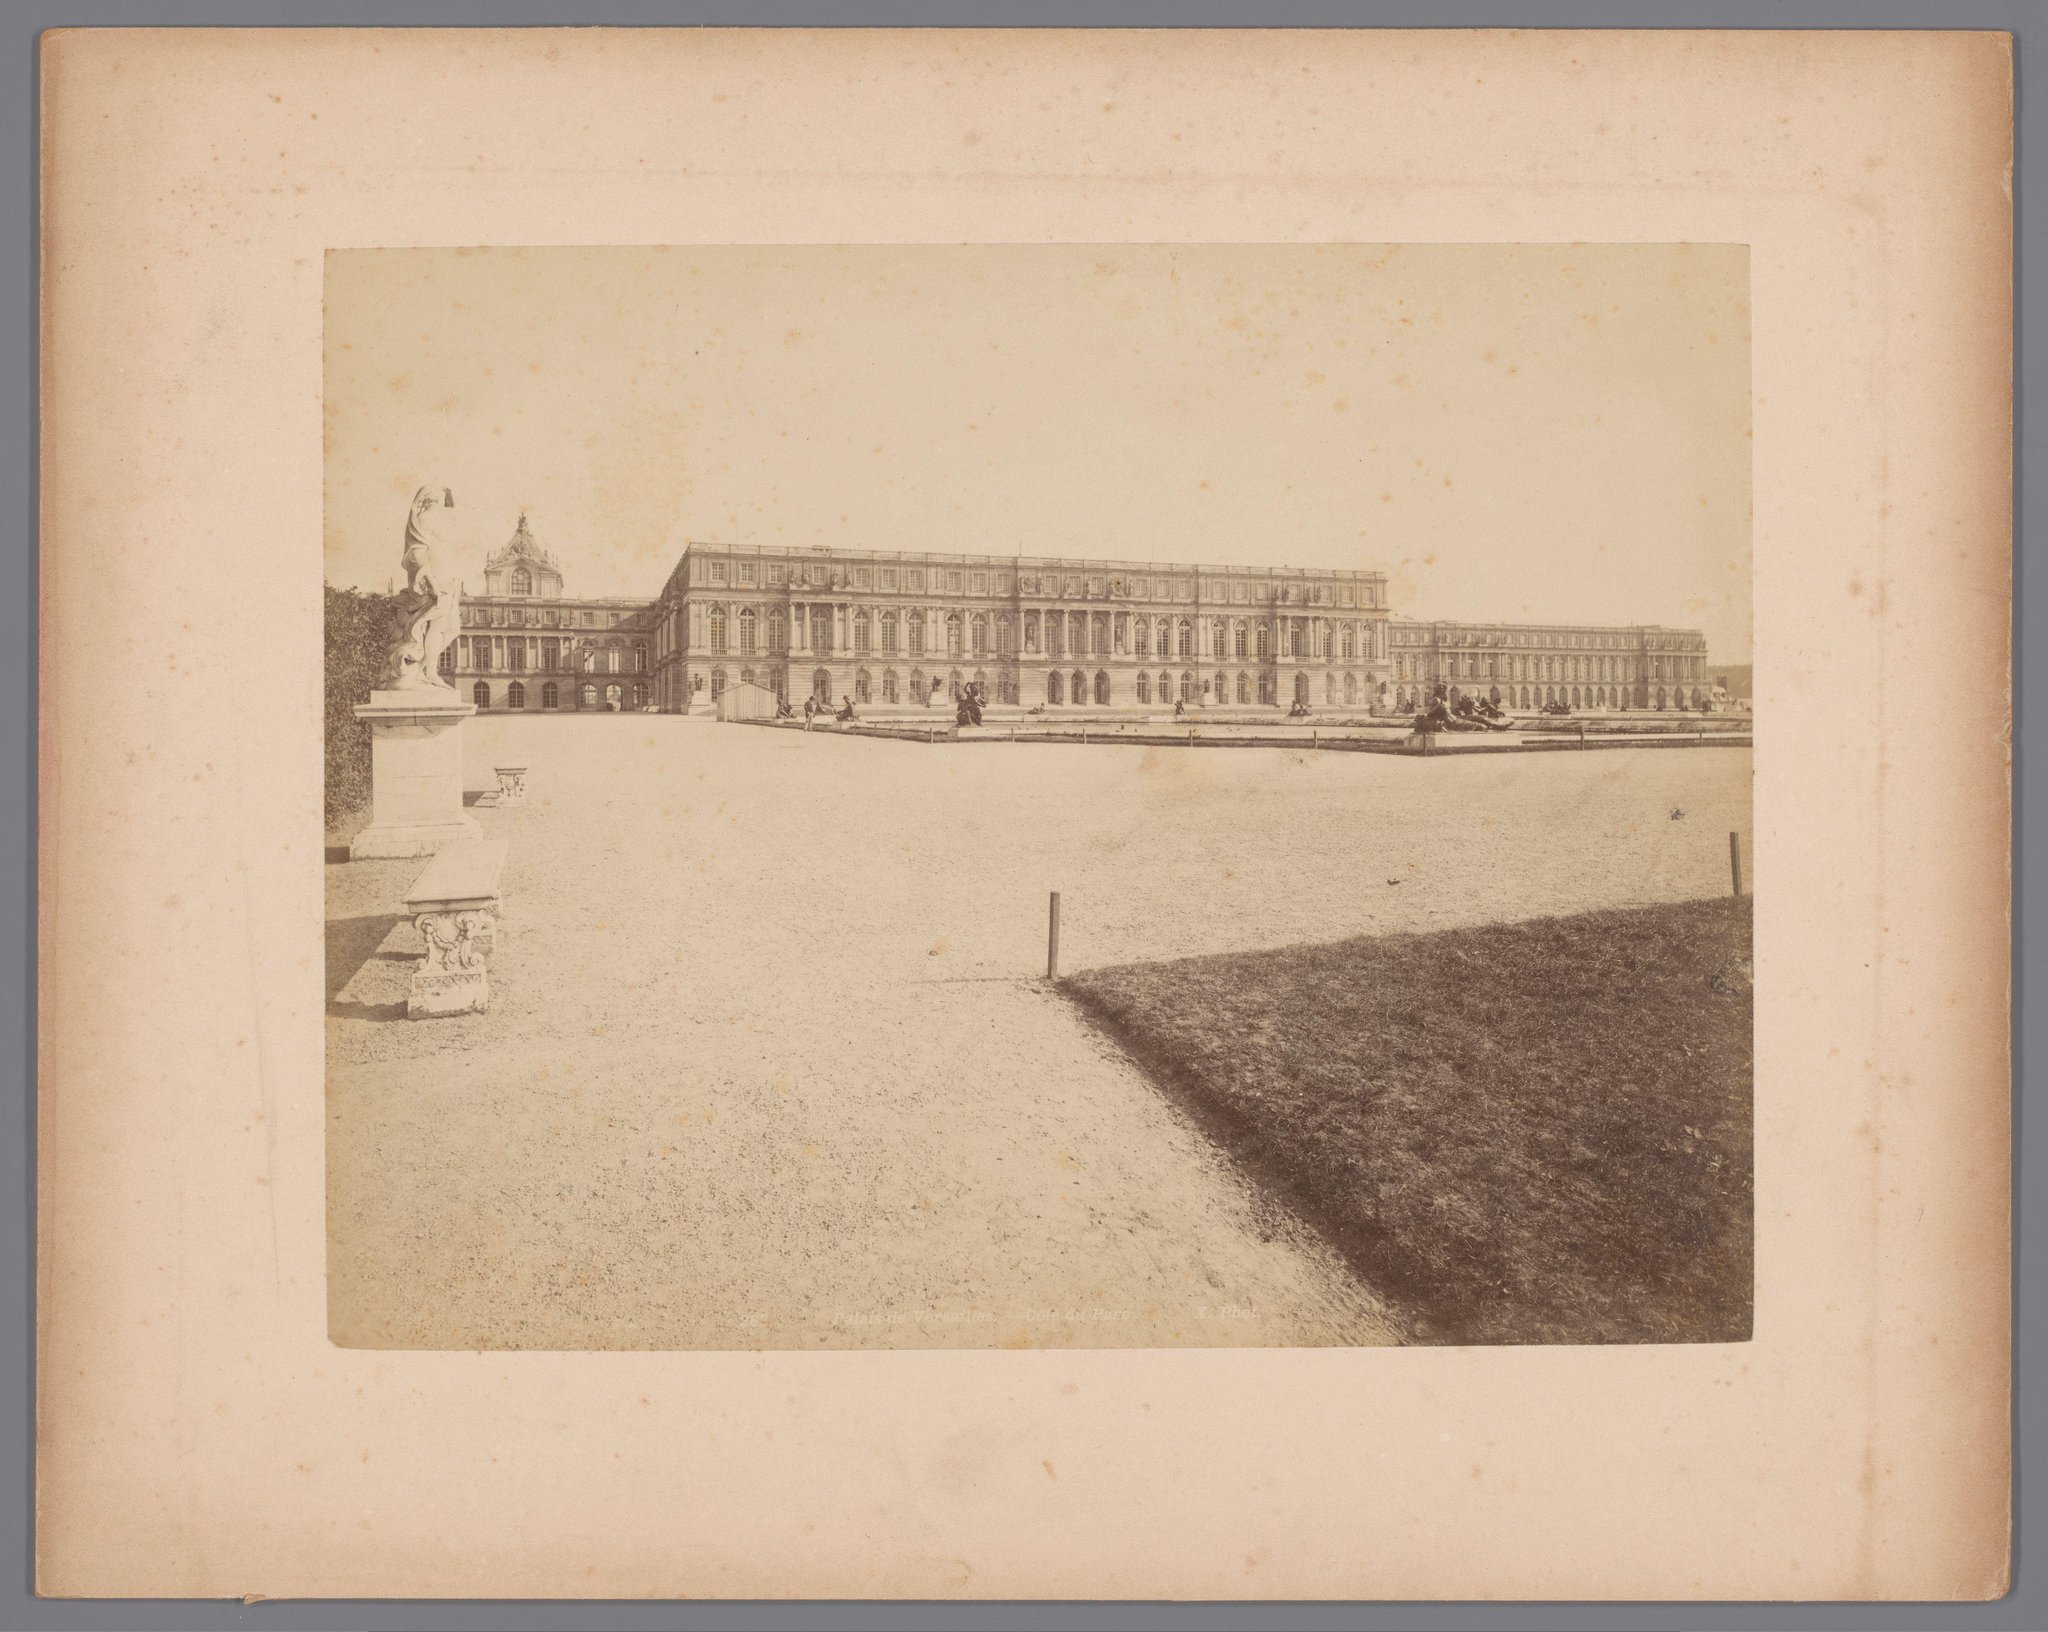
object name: photograph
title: Paleis van Versailles, vanuit de tuinkant gezien, Frankrijk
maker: Anonymous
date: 1880-1910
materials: cardboard, photographic support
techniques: albumen print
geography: france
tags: kasteel van versailles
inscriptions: caption: ‘Palais de Versailles.-Côté du Parc X. Phot.’